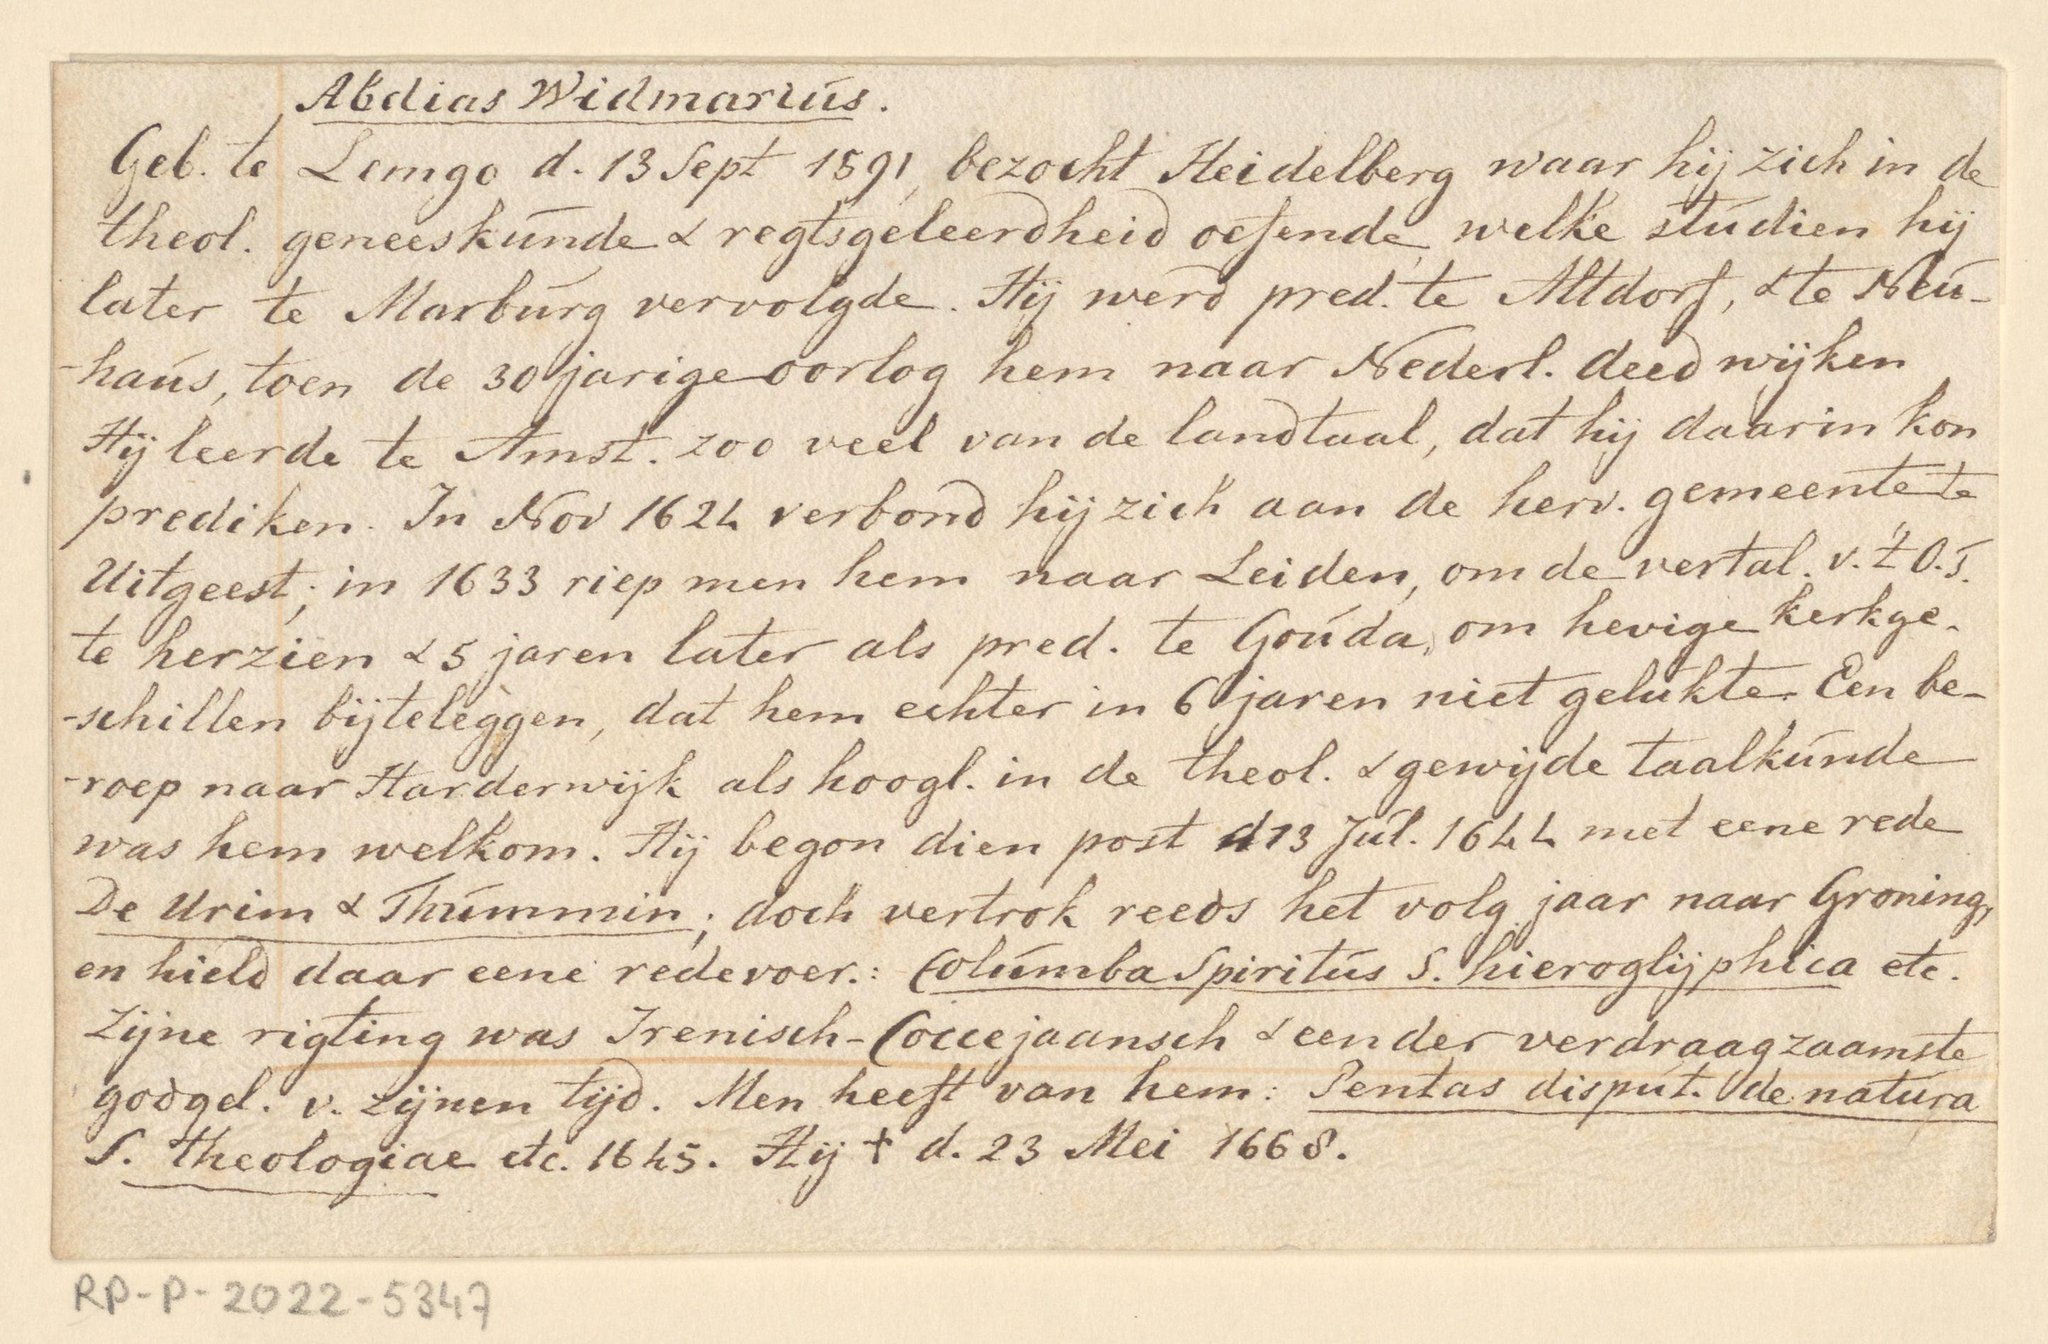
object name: text sheet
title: Biografie van Abdias Widmarius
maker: Anonymous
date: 1800-1899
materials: ink, paper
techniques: pen, writing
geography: netherlands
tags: predikant, theoloog, professor, abdias widmarius